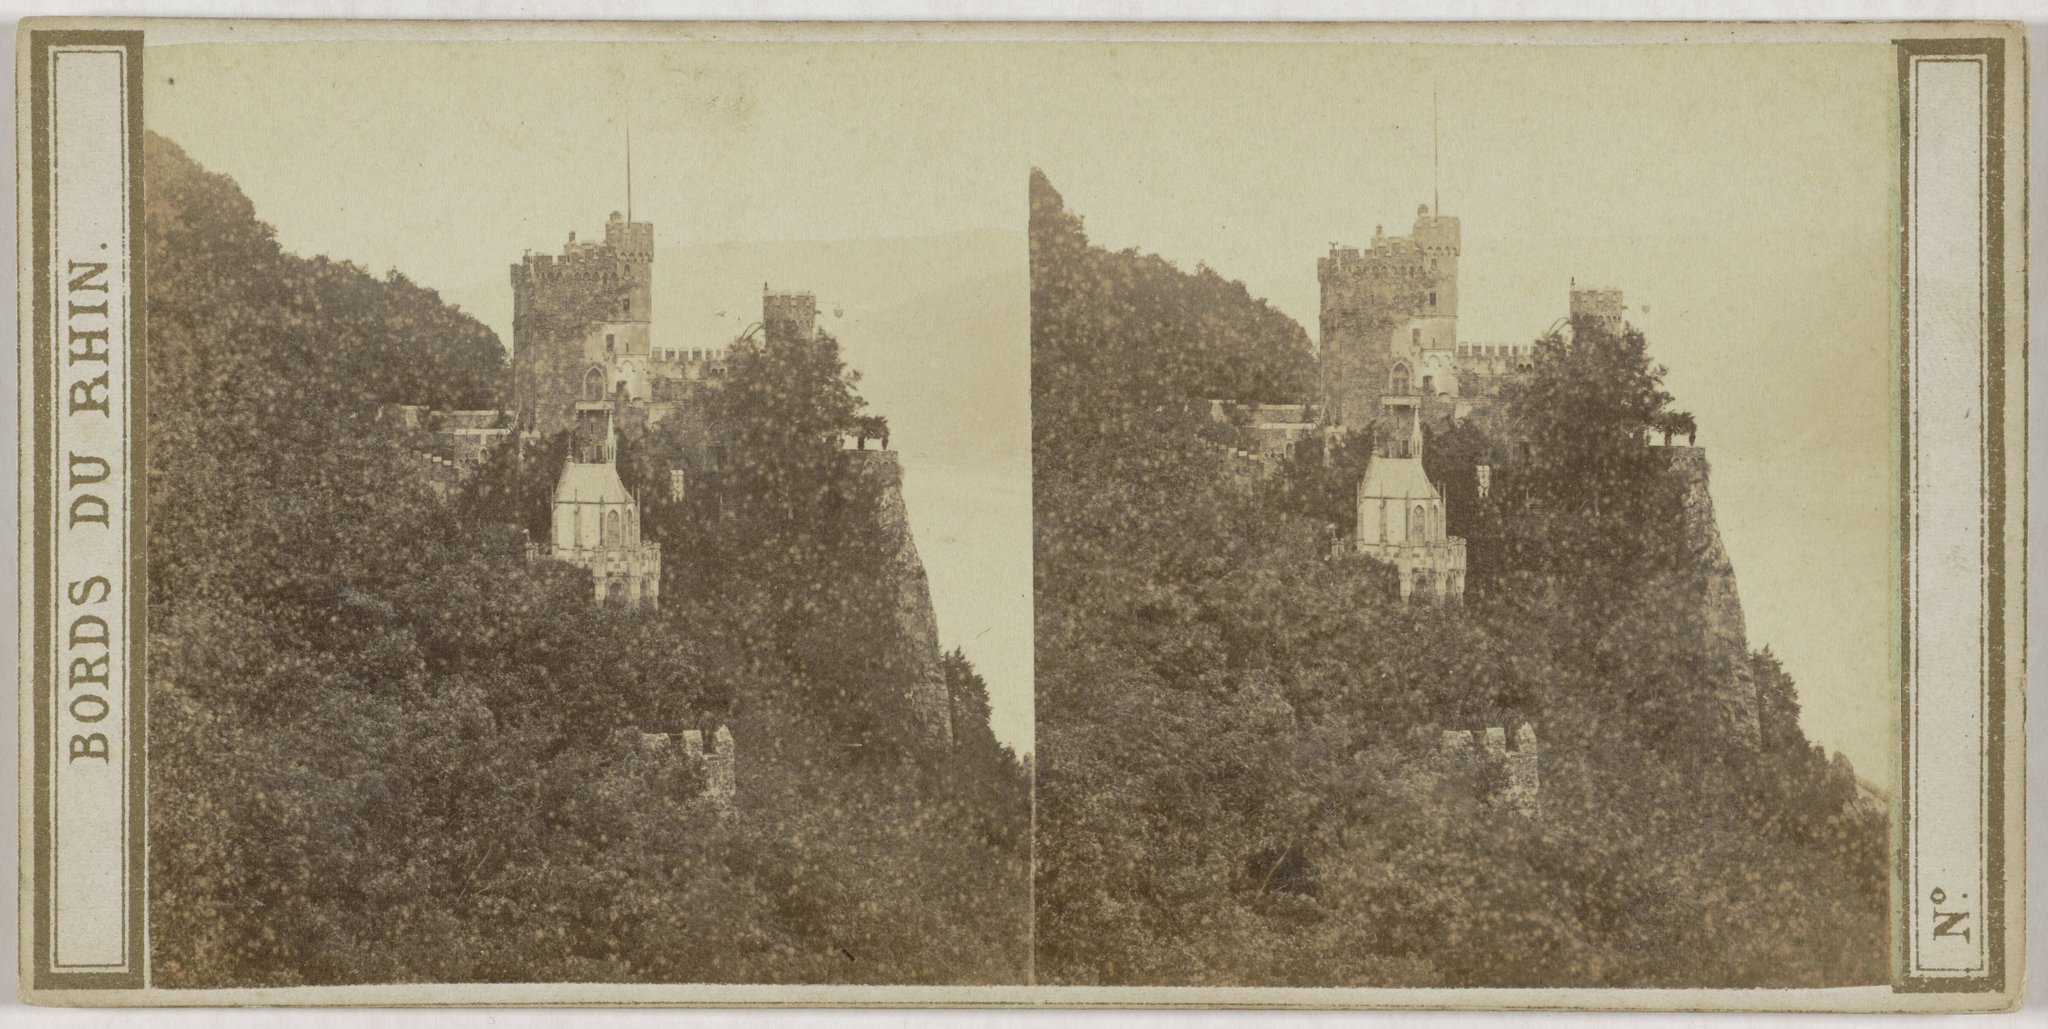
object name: stereograph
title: Burcht Rheinstein nabij Trechtingshausen aan de Rijn, Duitsland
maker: alexandre bertrand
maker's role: fotograaf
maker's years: 1822-1889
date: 1865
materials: cardboard, paper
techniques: albumen print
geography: trechtingshausen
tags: landscape with tower or castle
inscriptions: number: ‘120.’